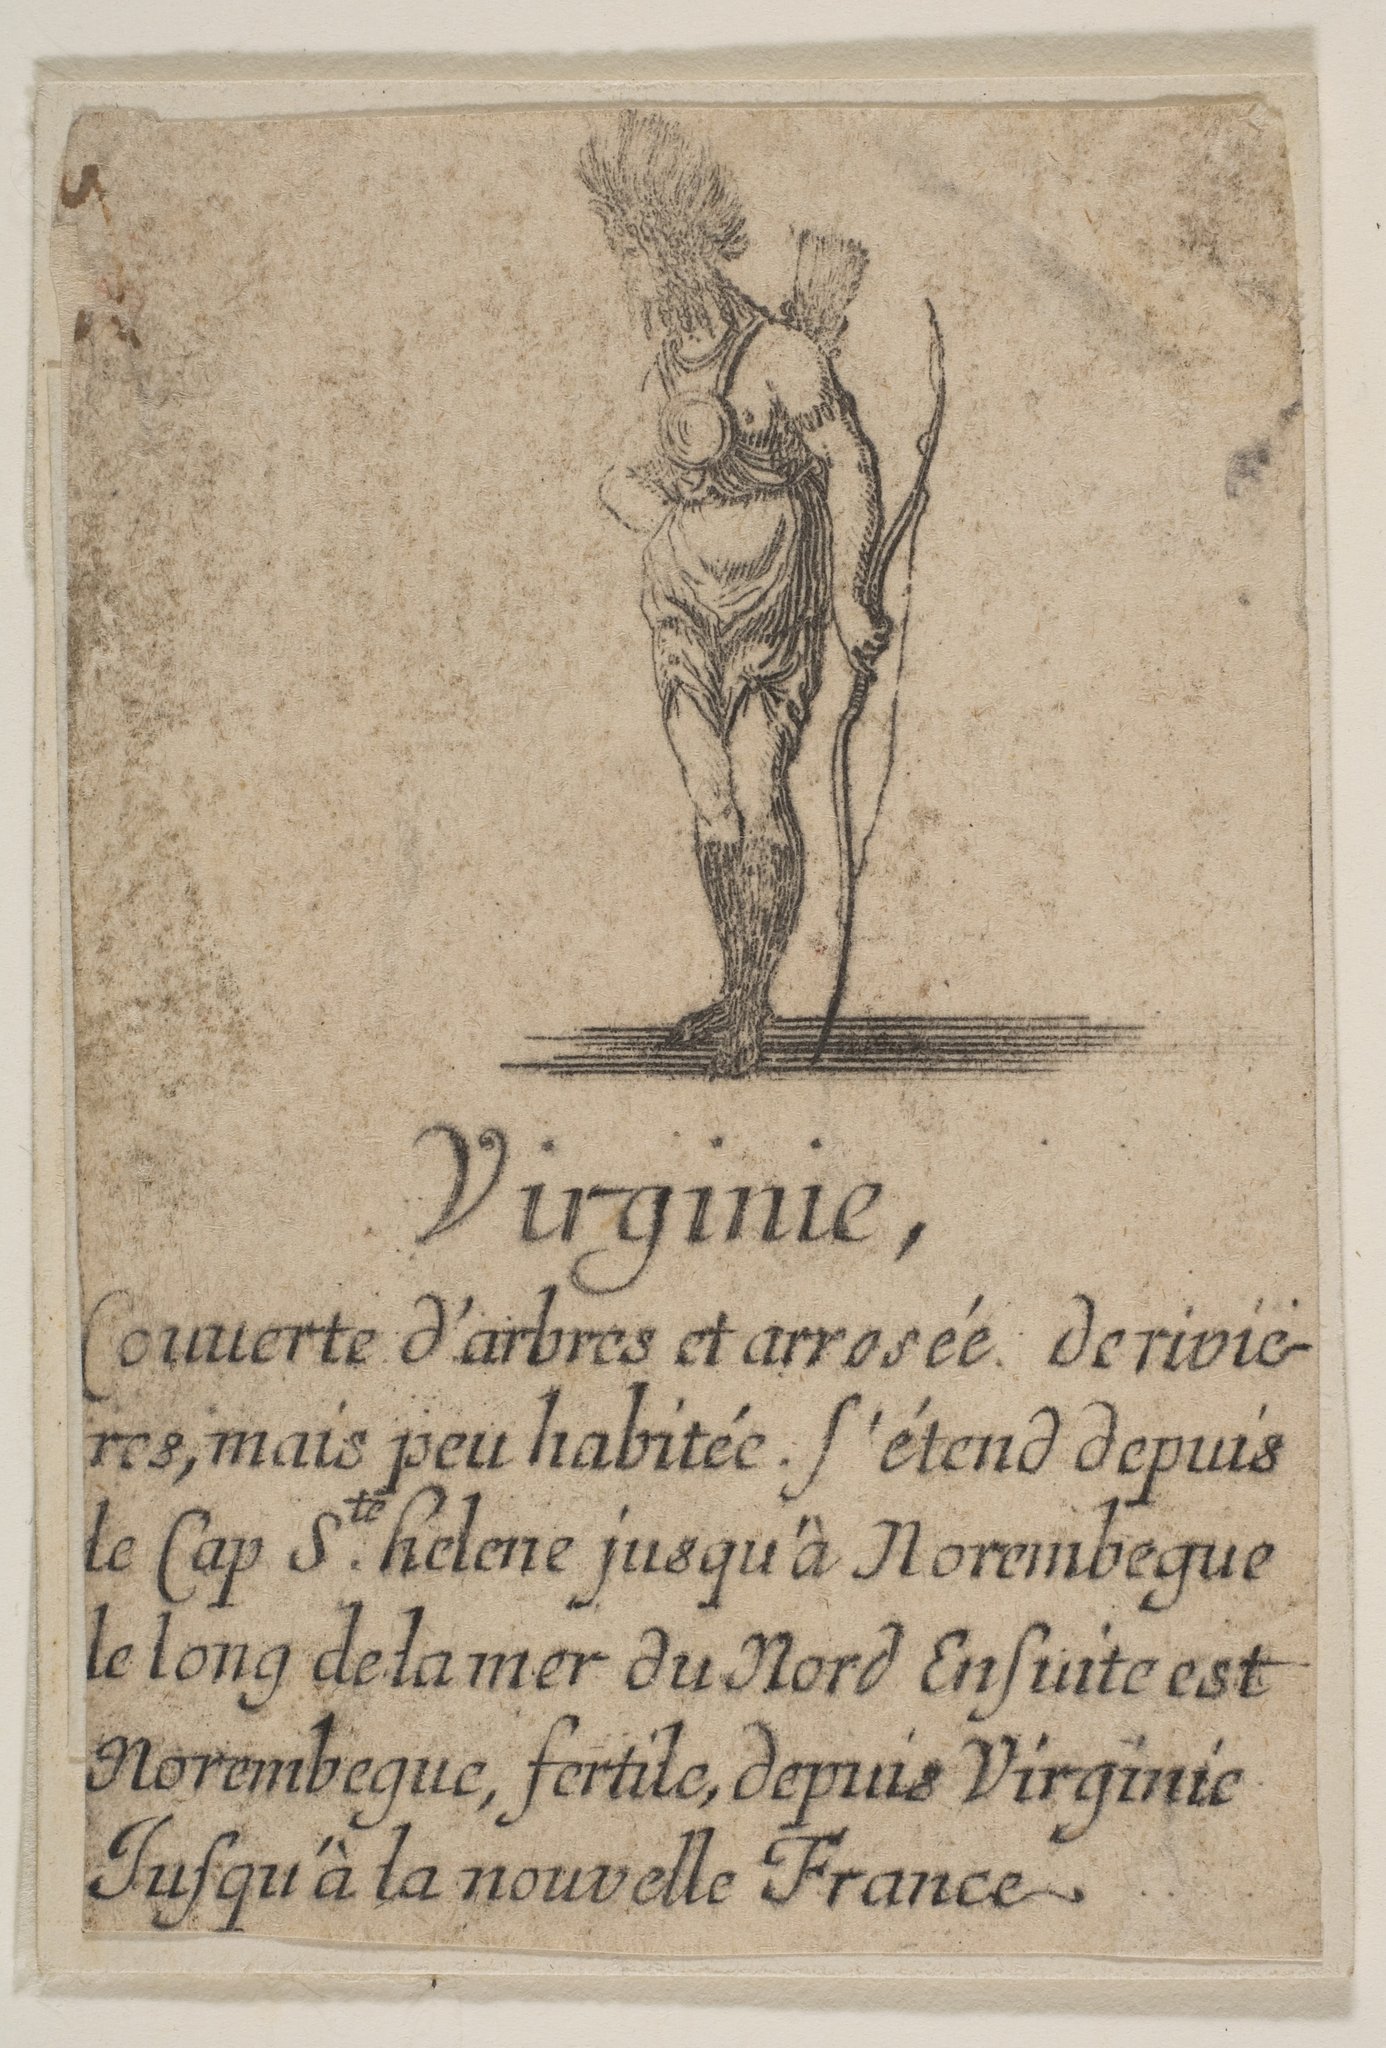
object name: print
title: Virginia, from the playing cards "Jeu de la Géographie"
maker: stefano della bella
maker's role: artist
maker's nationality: italian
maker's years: 1610-1664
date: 1644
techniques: etching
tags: bow and arrow,men